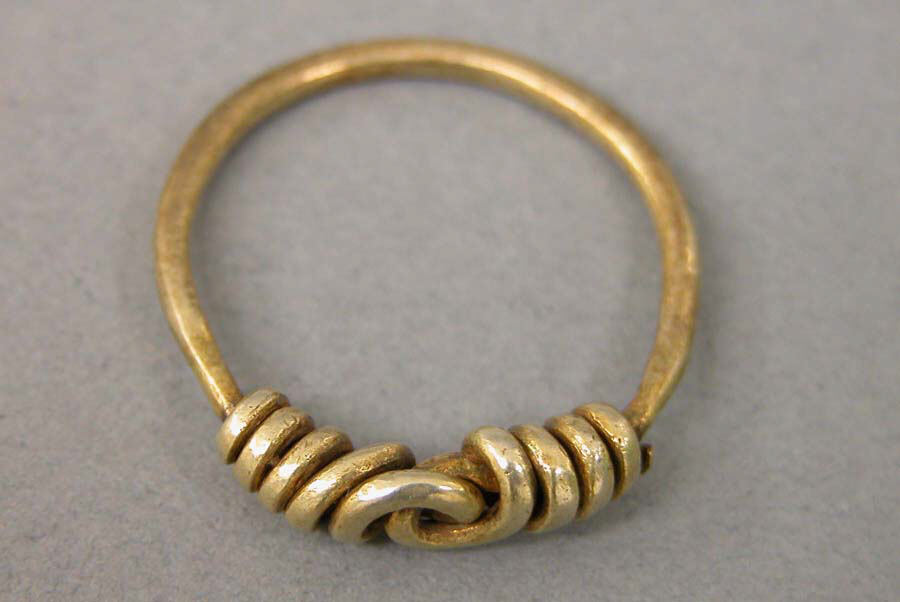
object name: ring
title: Ring with Twisted Coil Motif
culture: indonesian, javanese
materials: gold